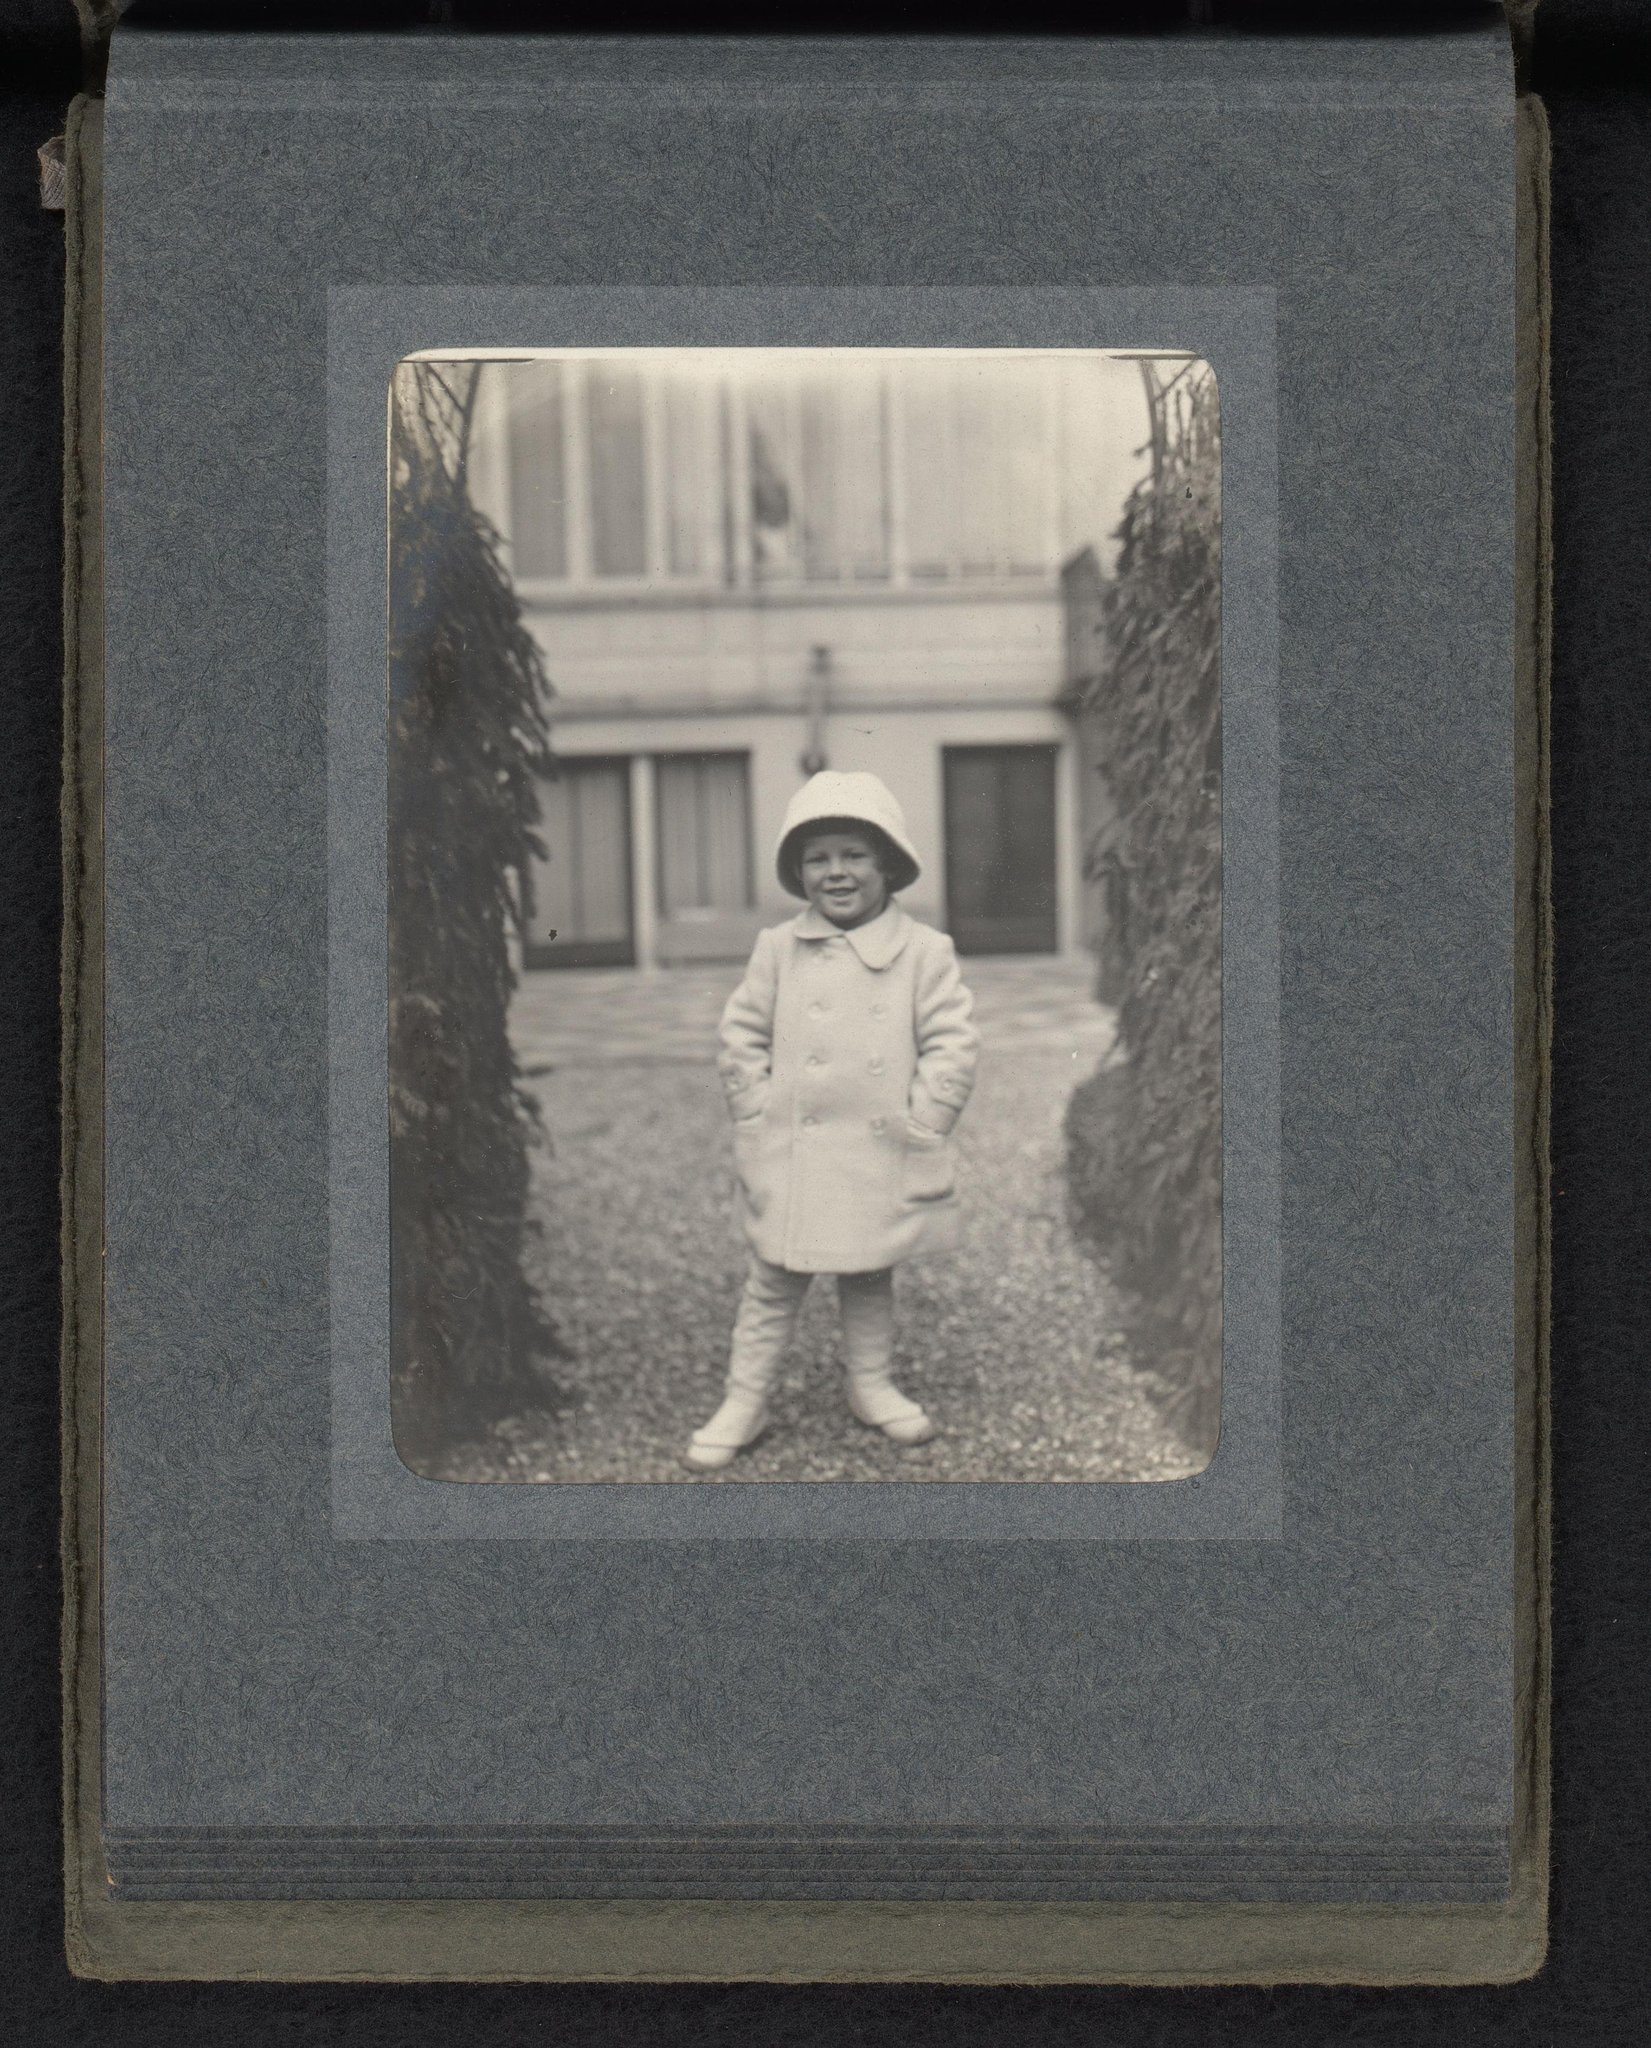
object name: photograph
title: Portret van Cay van den Berg in de tuin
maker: hendrik herman van den berg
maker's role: amateurfotograaf, jurist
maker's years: 1875-1944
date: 1912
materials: paper, cardboard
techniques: gelatin silver print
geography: amsterdam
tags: carel frederik van den berg (cay), toddler, garden, historical persons